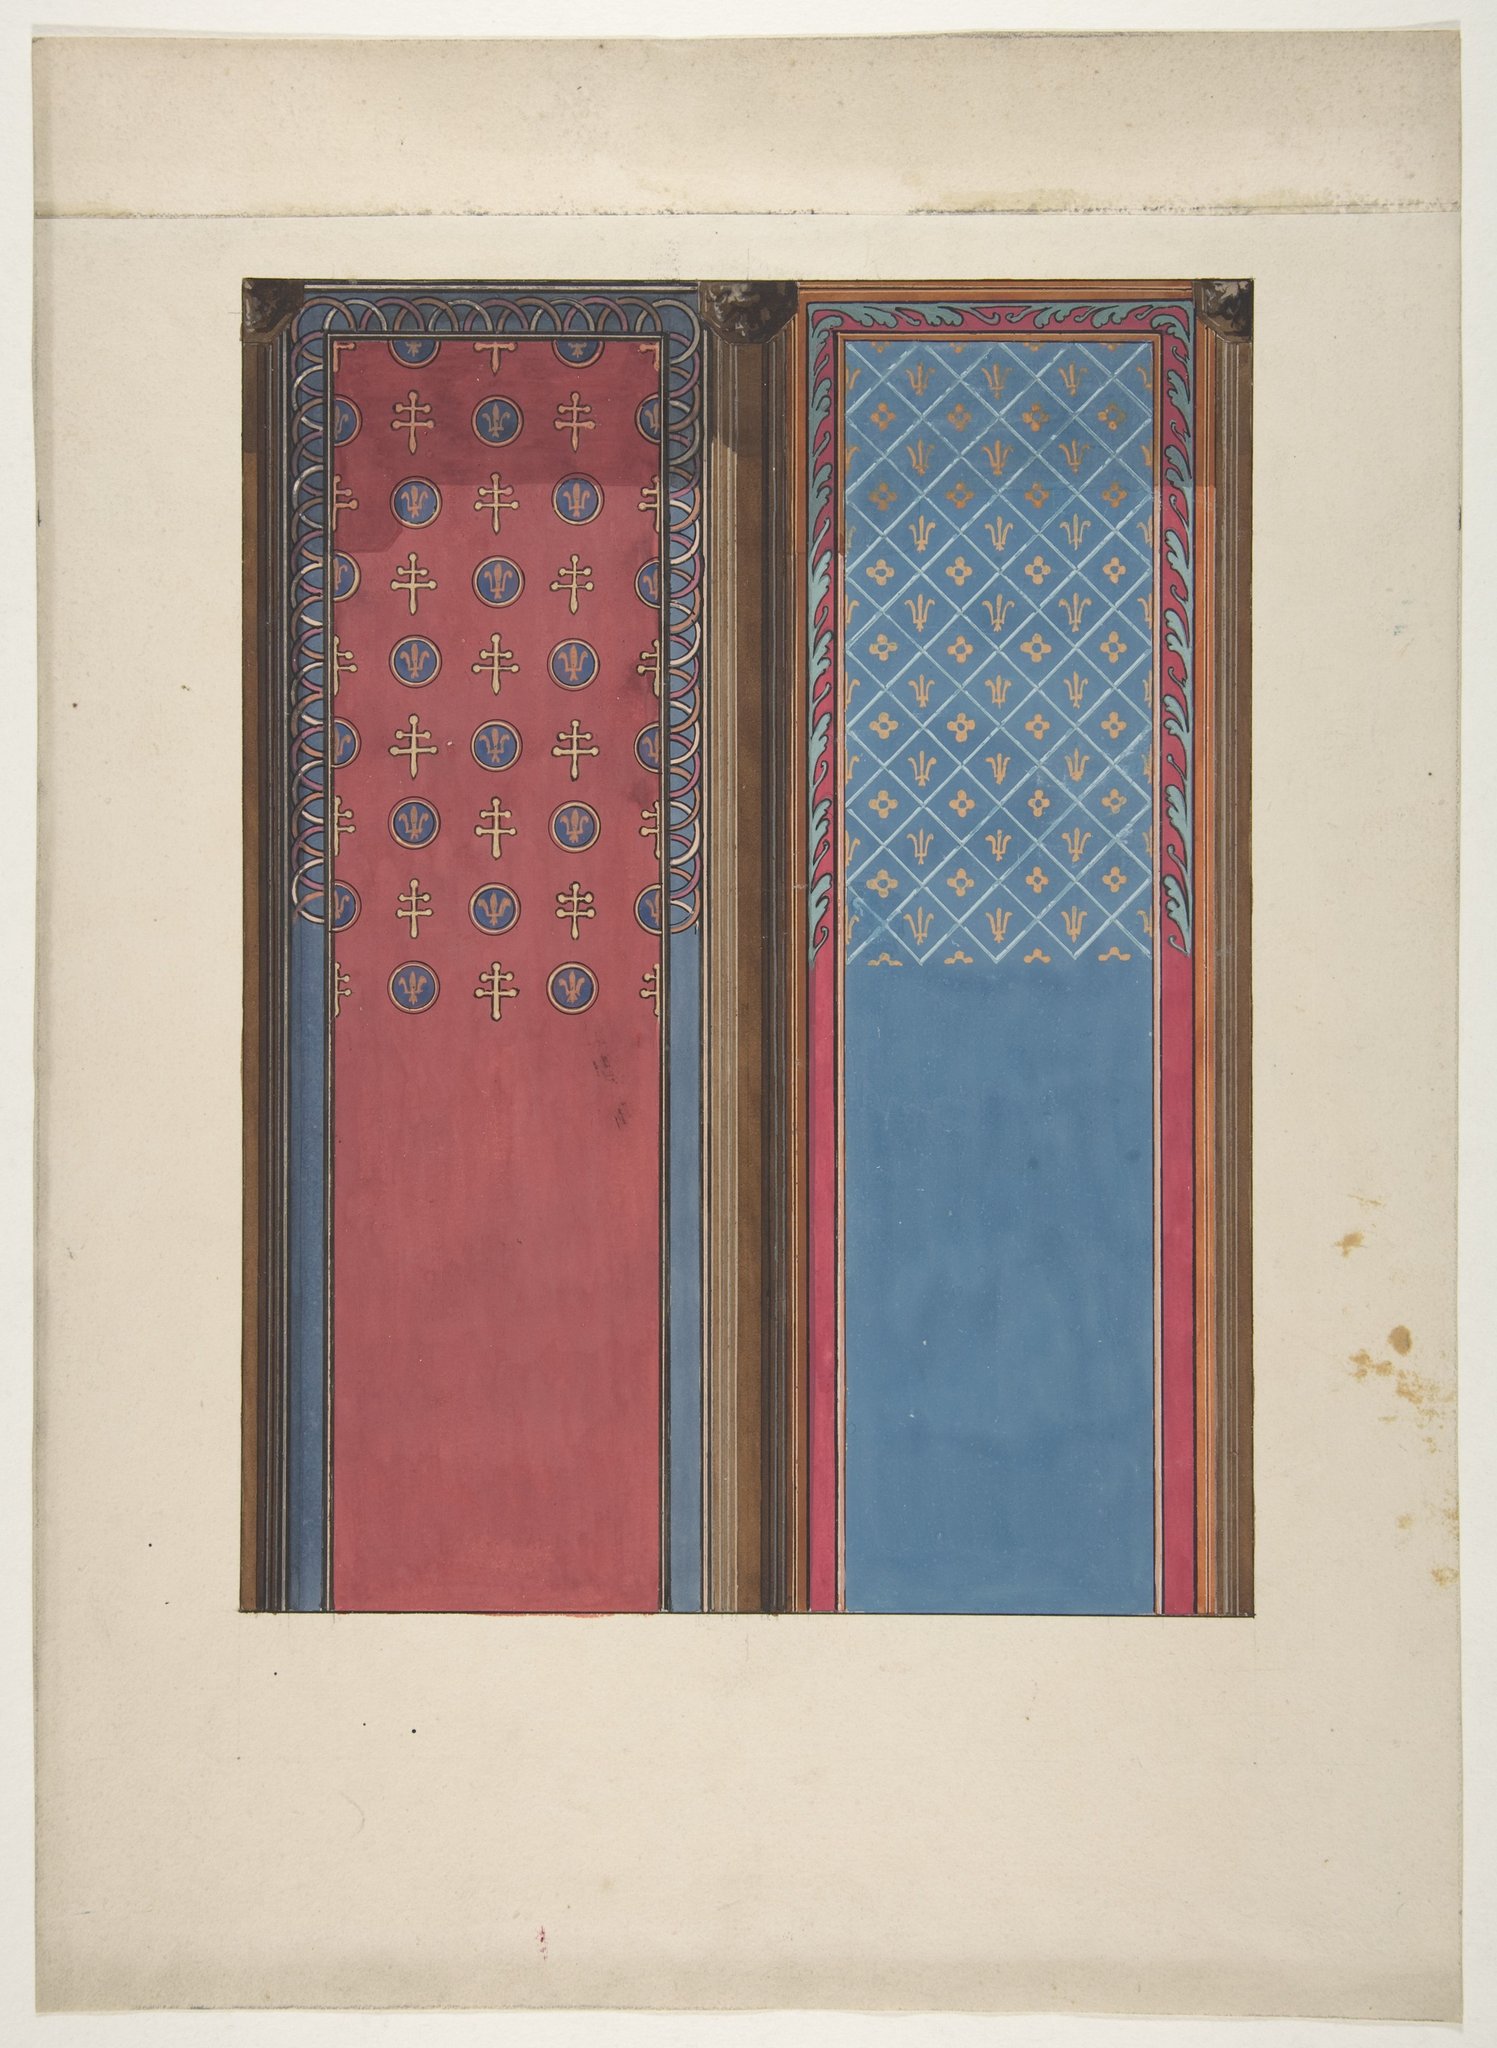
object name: drawing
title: Design for the painted decoration of panels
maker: jules-edmond-charles lachaise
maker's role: artist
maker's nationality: french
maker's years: 1897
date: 1851-1900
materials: gouache, ink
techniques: pen